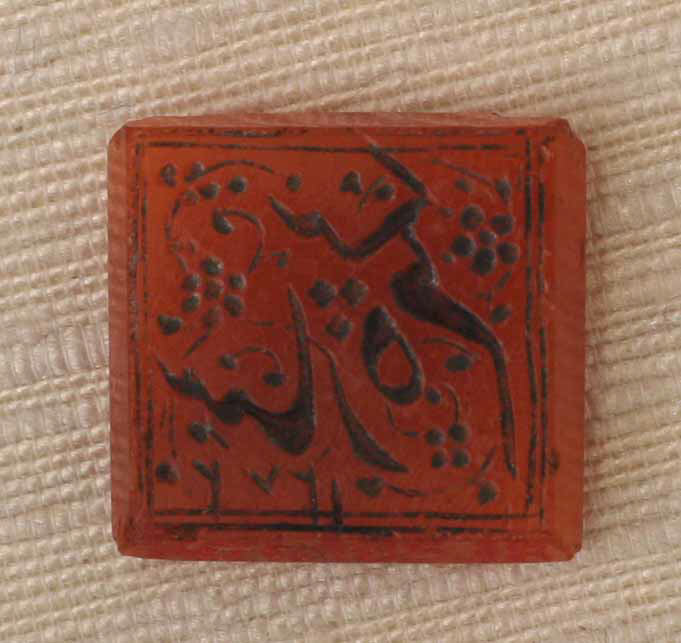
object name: stamp seal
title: Seal Stamp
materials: stone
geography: iran